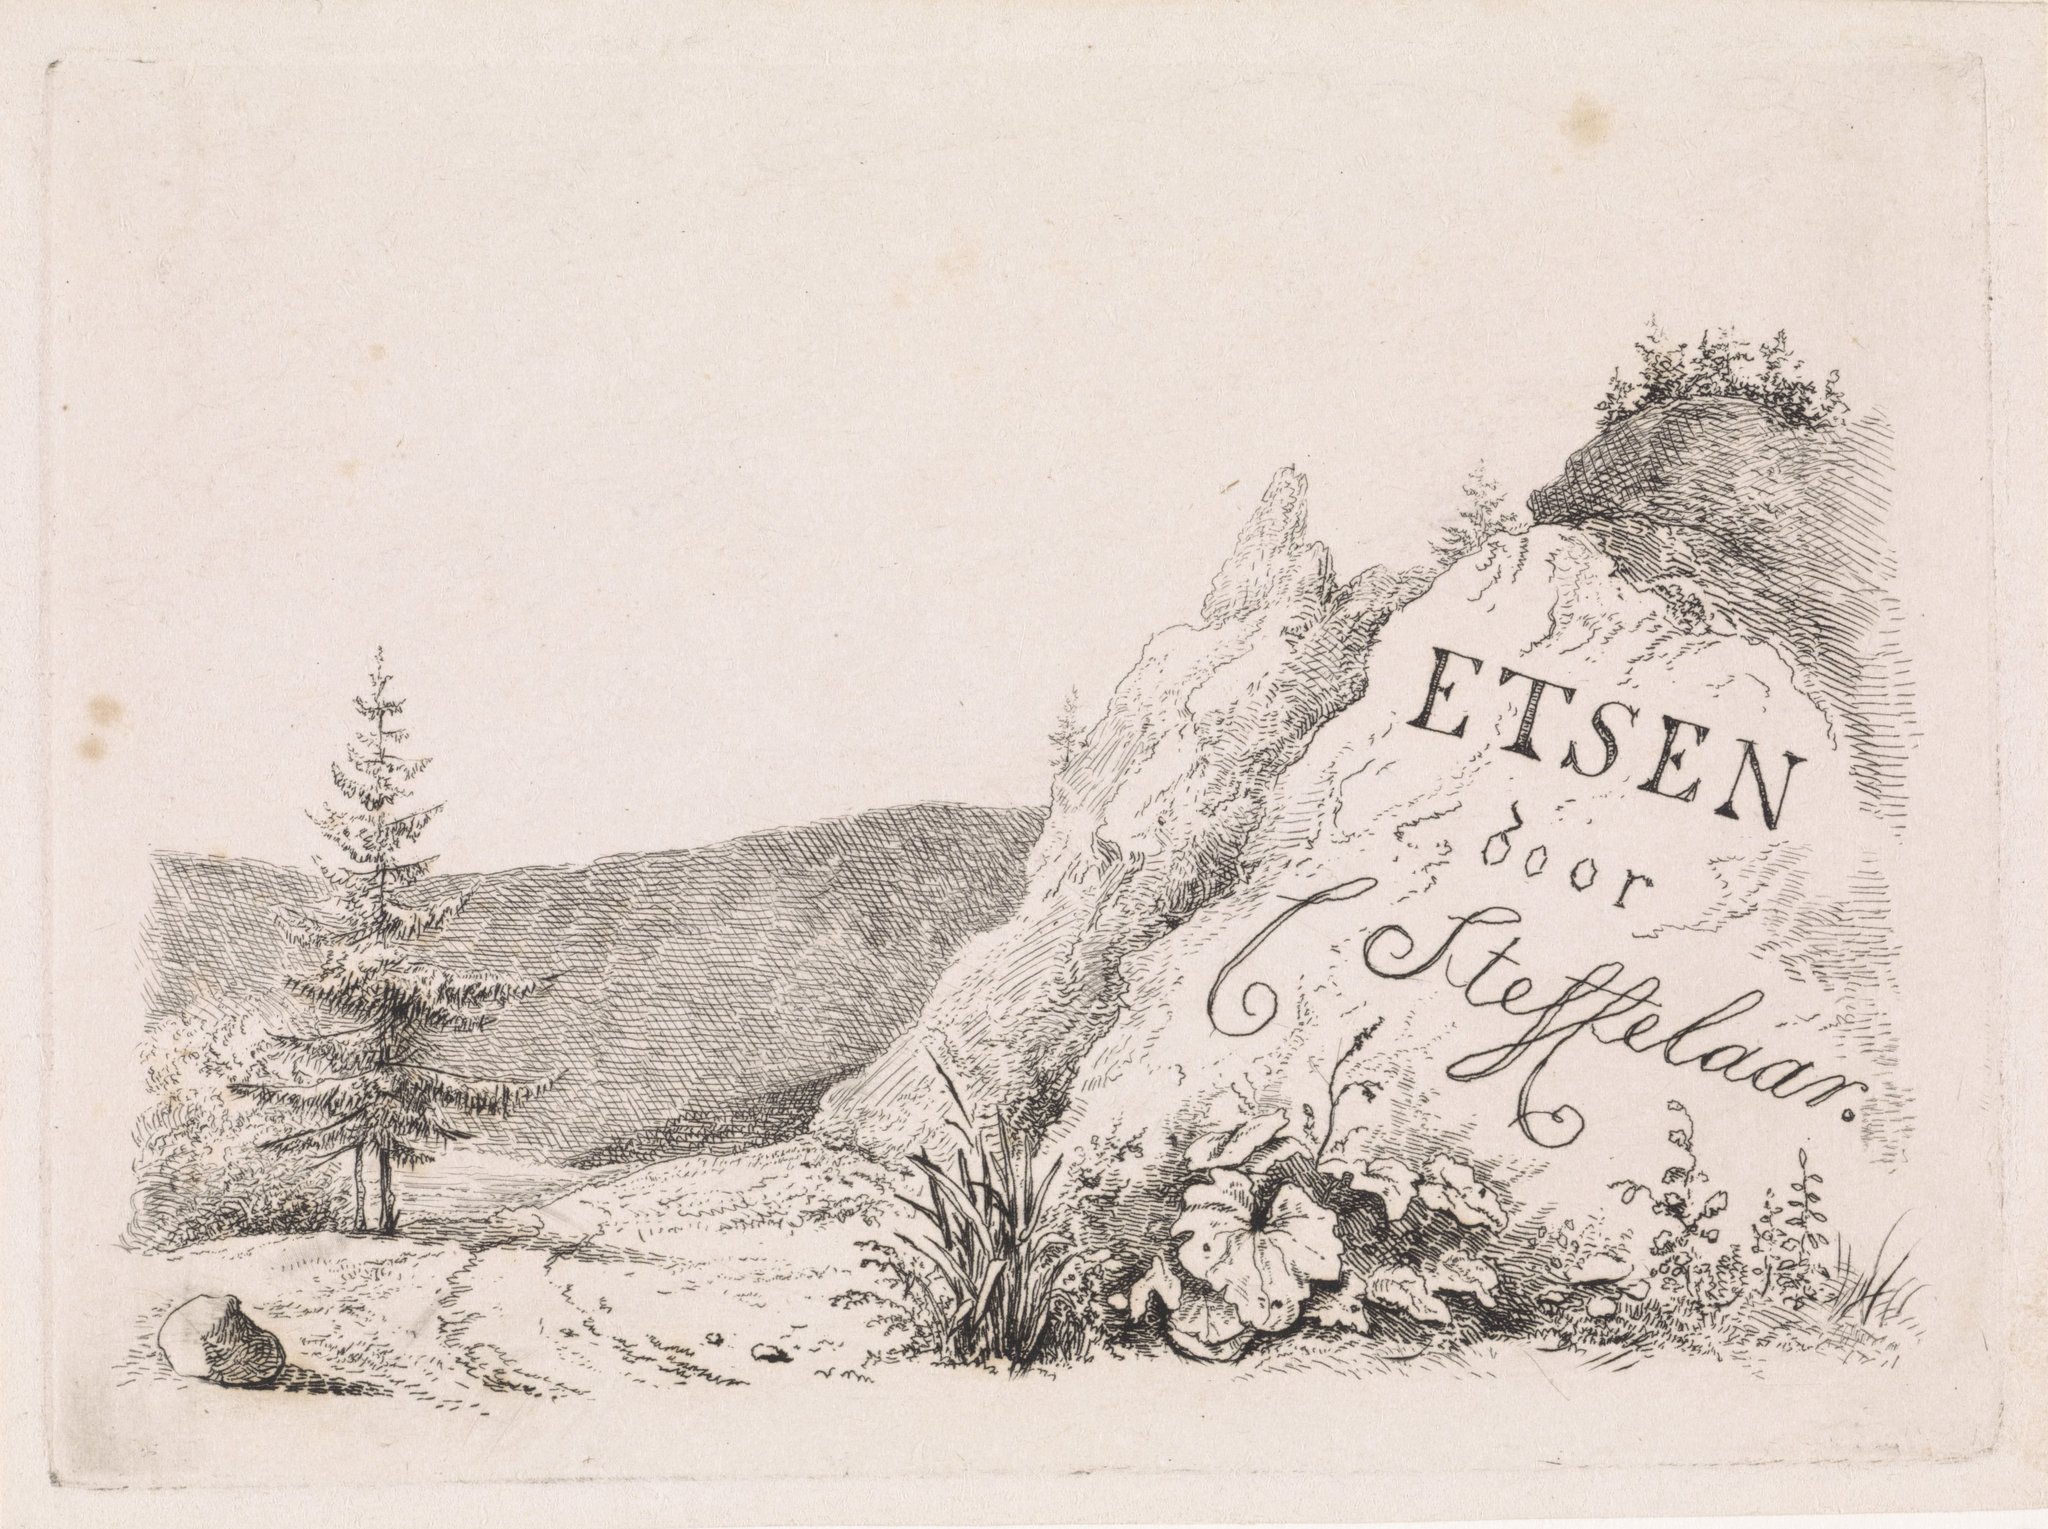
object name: print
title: Etsen door C. Steffelaar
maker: cornelis steffelaar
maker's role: draughtsman, painter, print maker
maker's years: 1797-1861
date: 1807-1861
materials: paper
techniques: etching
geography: amsterdam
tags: landscapes in the temperate zone, trees: fir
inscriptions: collector's mark: Lugt 2228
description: Rechts op de voorgrond een steen langs een pad. Links een naaldboom.